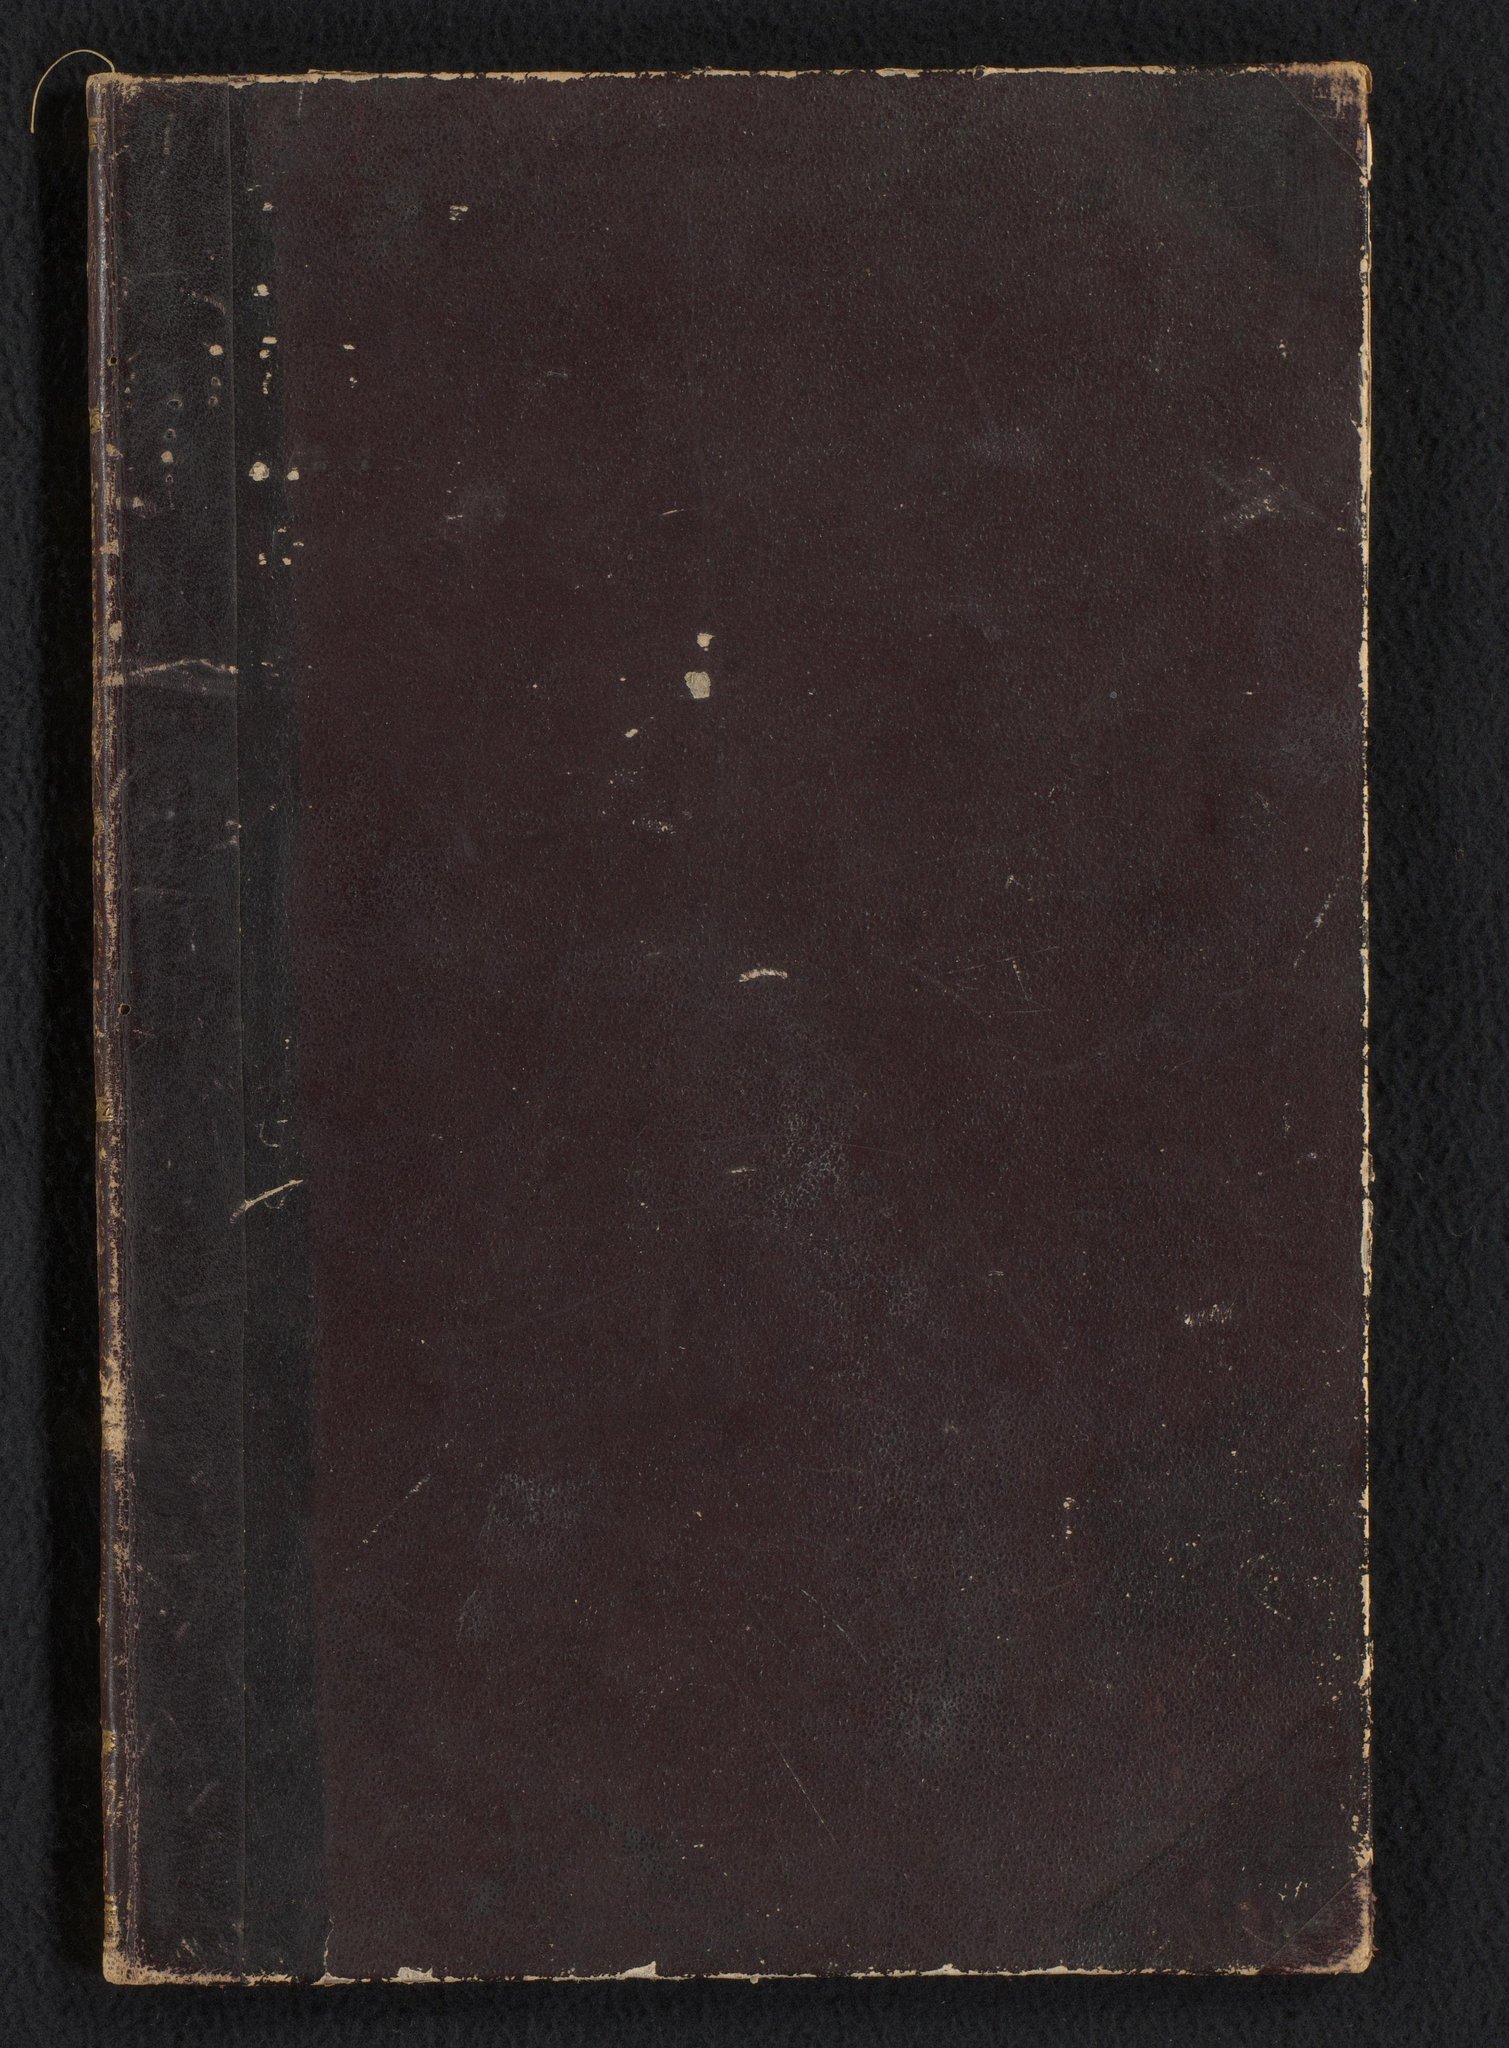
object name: book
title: La photographie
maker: Anonymous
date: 1875-1938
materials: cardboard, leather, paper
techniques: letterpress printing, engraving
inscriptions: bookplate: ‘EX/ F/S/J/ LIBRIS/ NOV 1982’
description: Samengestelde bundel met artikelen uit verschillende edities van 'Magasin pittoresque' gewijd aan fotografie.